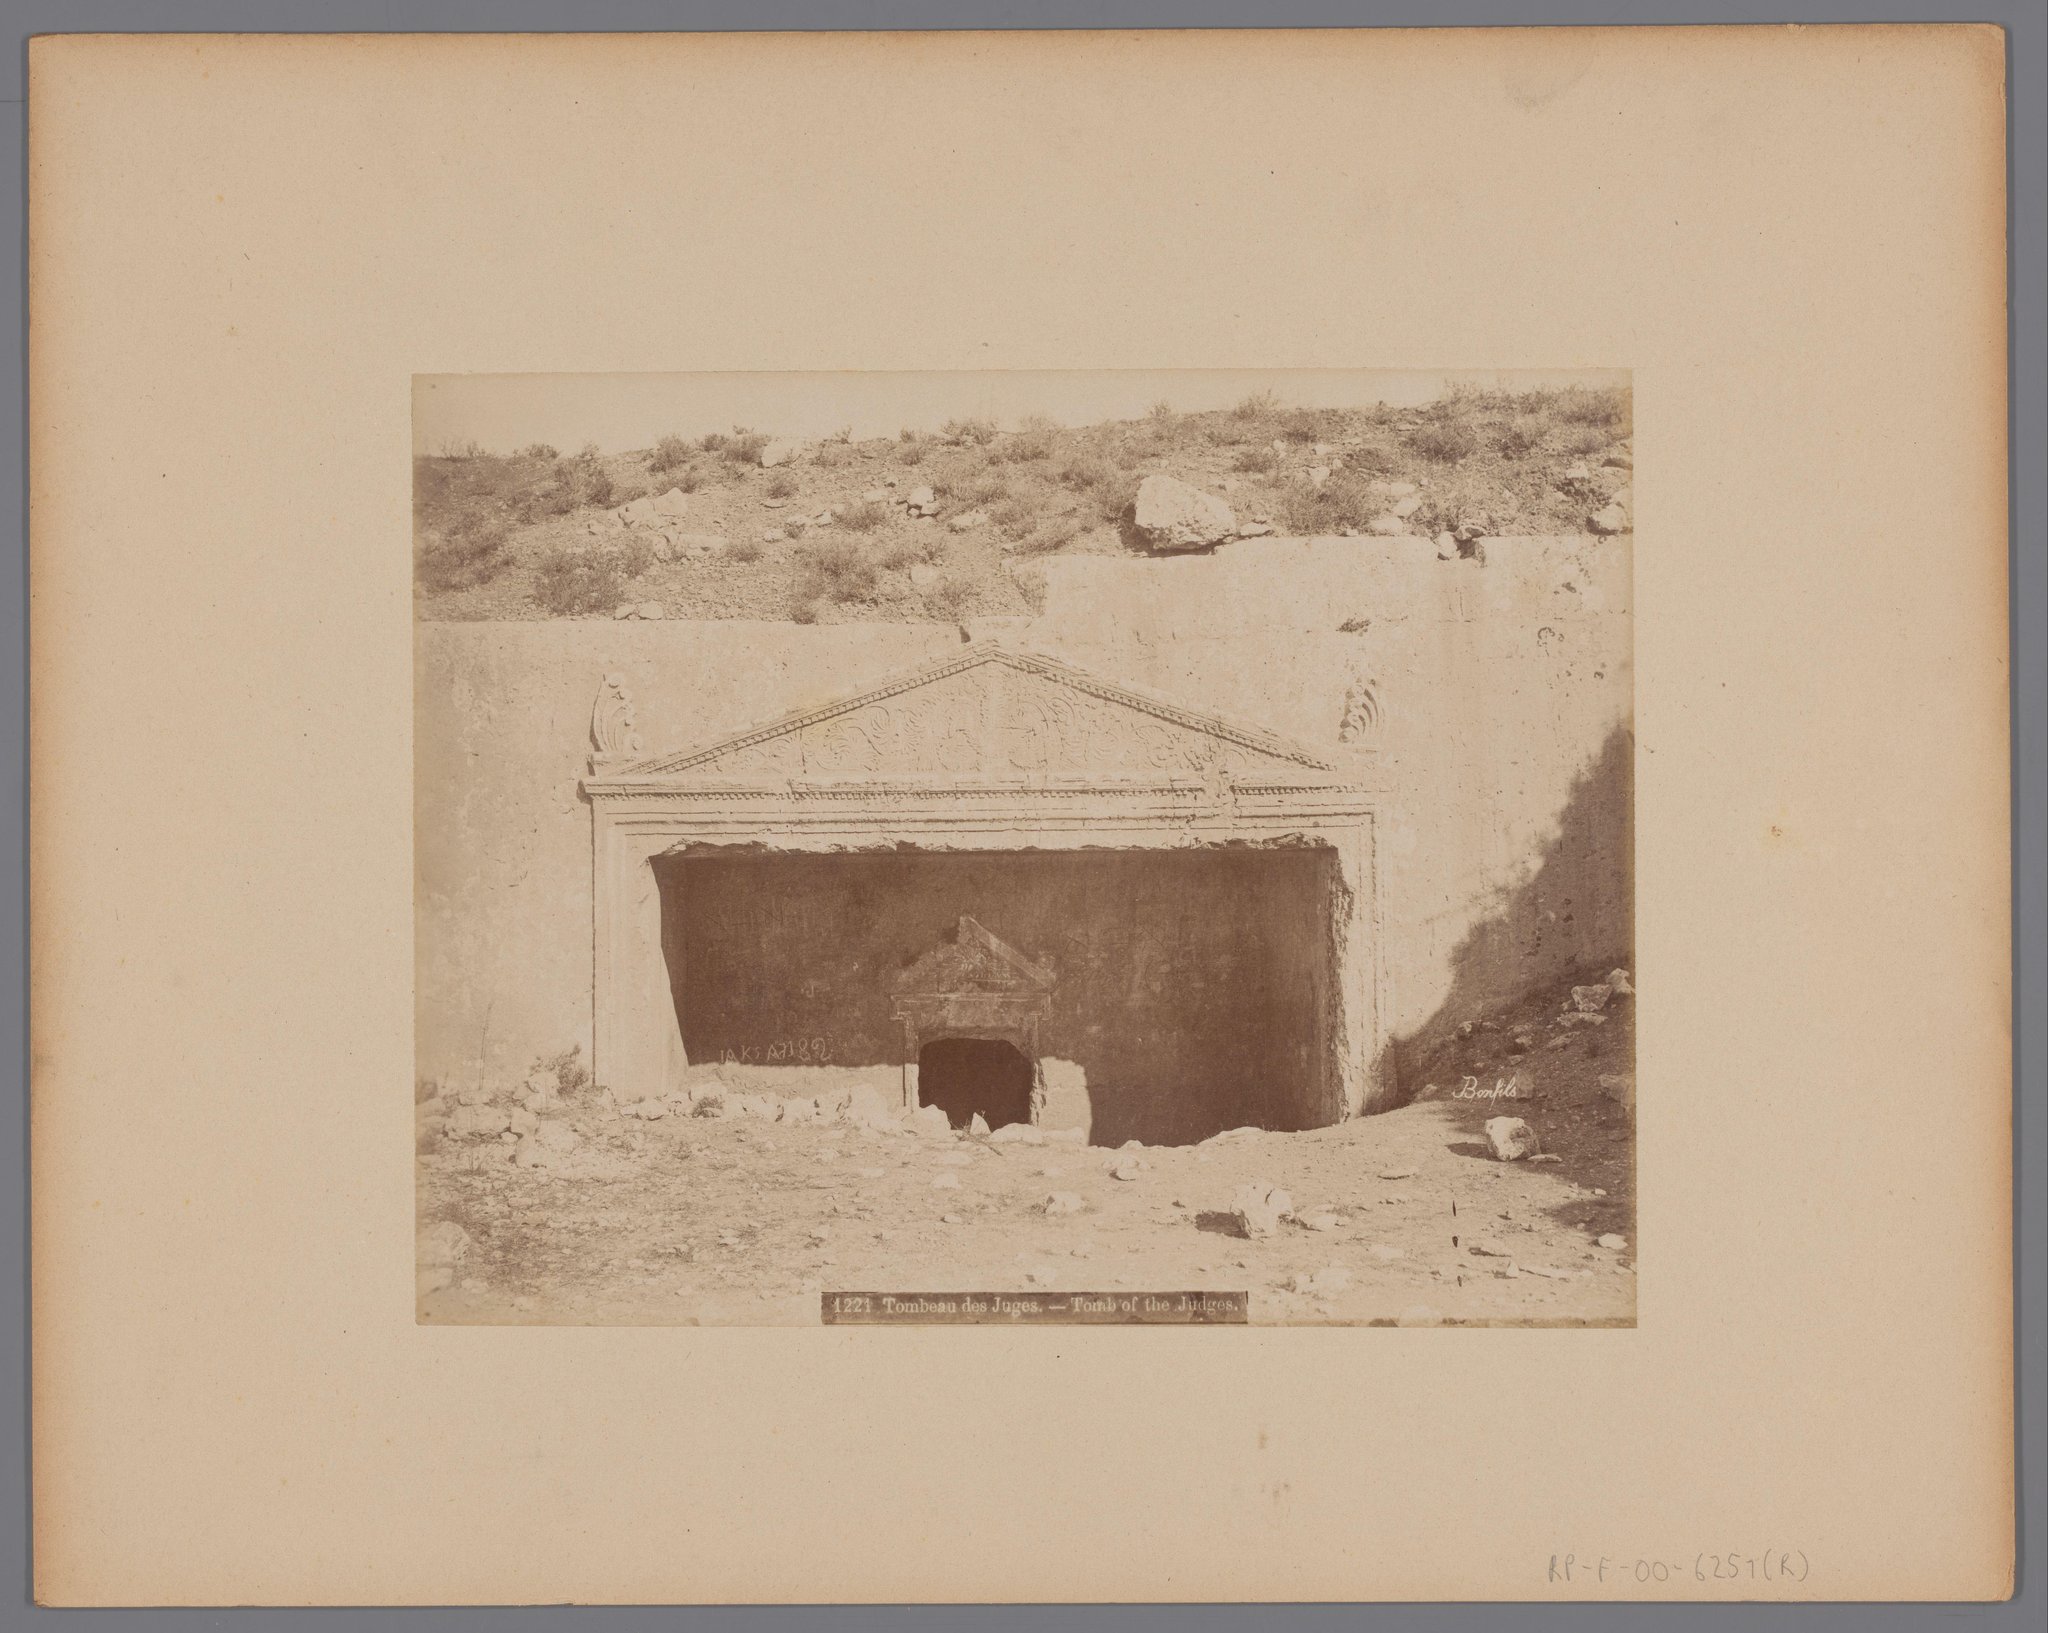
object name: photograph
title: Graftombe van de rechters, bij Jeruzalem ["Tombeau des Juges/Tomb of the Judges"]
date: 1850-1900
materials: cardboard, photographic support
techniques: albumen print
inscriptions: inscription: ‘1221. Tombeau des Juges. - Tomb of the Judges.’, inscription: ‘Bonfils’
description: Graftombe van de rechters, bij Jeruzalem ["Tombeau des Juges/Tomb of the Judges"].